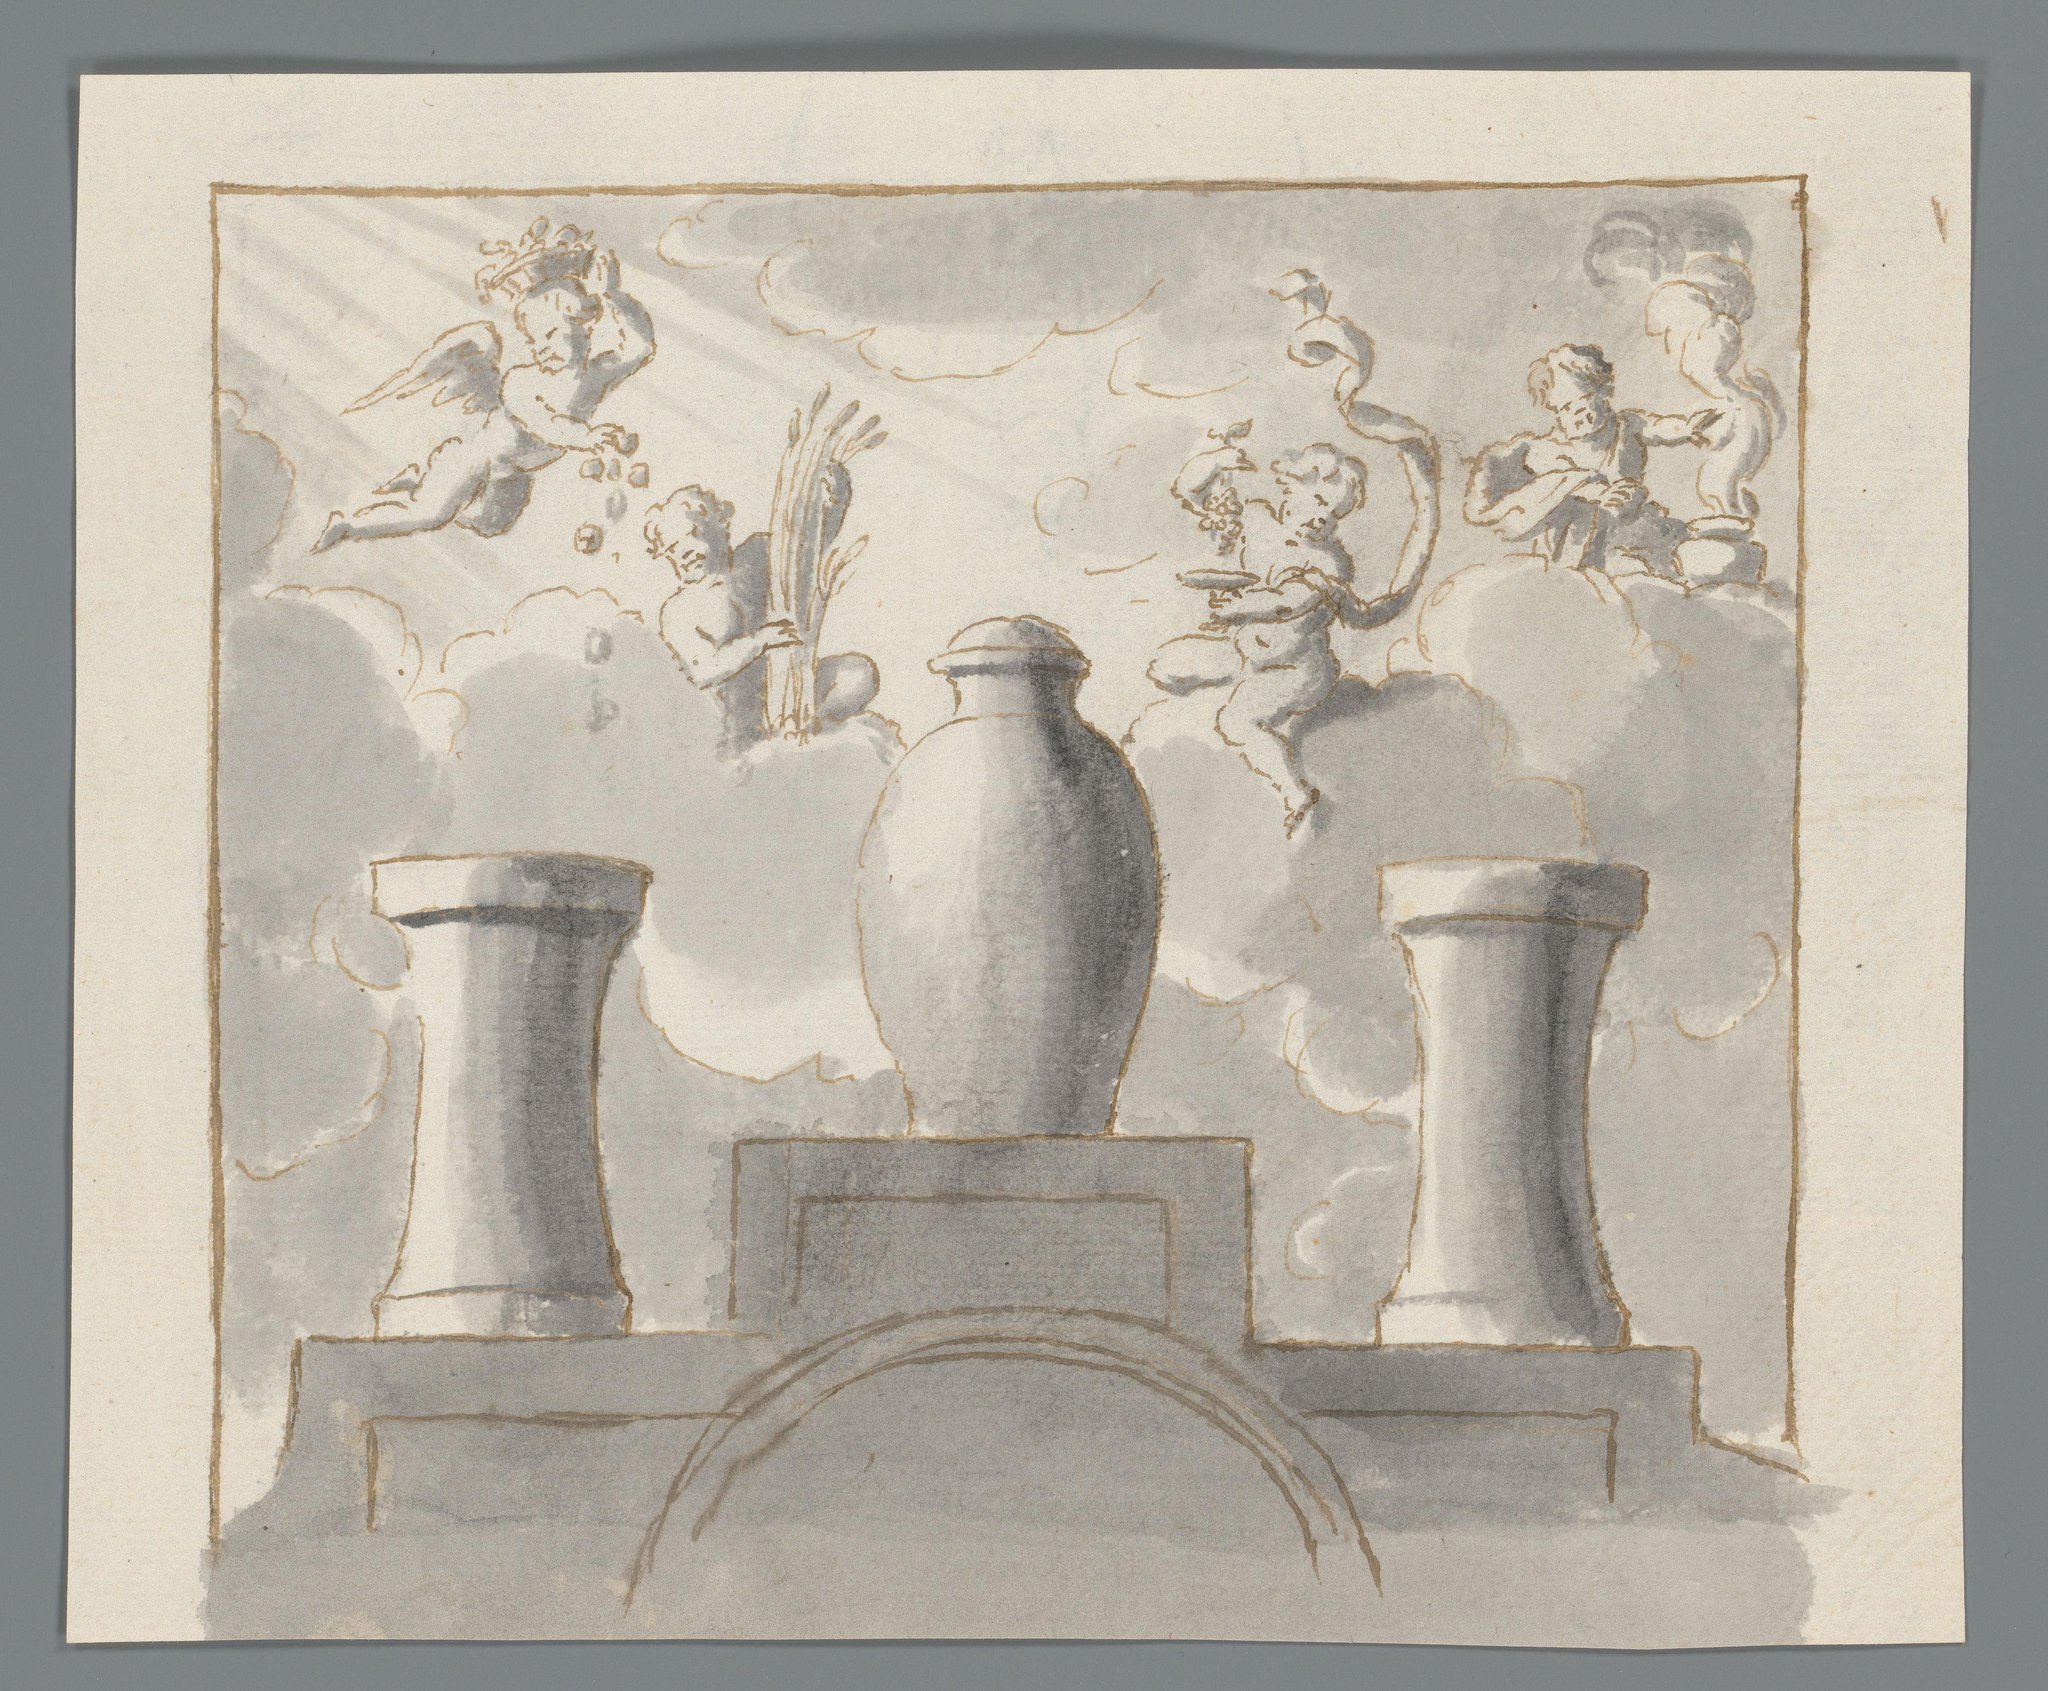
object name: drawing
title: Schouw met vazen voor een lucht met windgoden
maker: matthijs balen (1684-1766)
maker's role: draughtsman, painter, print maker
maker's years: 1684-1766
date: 1694-1766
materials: paper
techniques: brush, pen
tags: chimney-piece, mantelpiece, gods of the winds